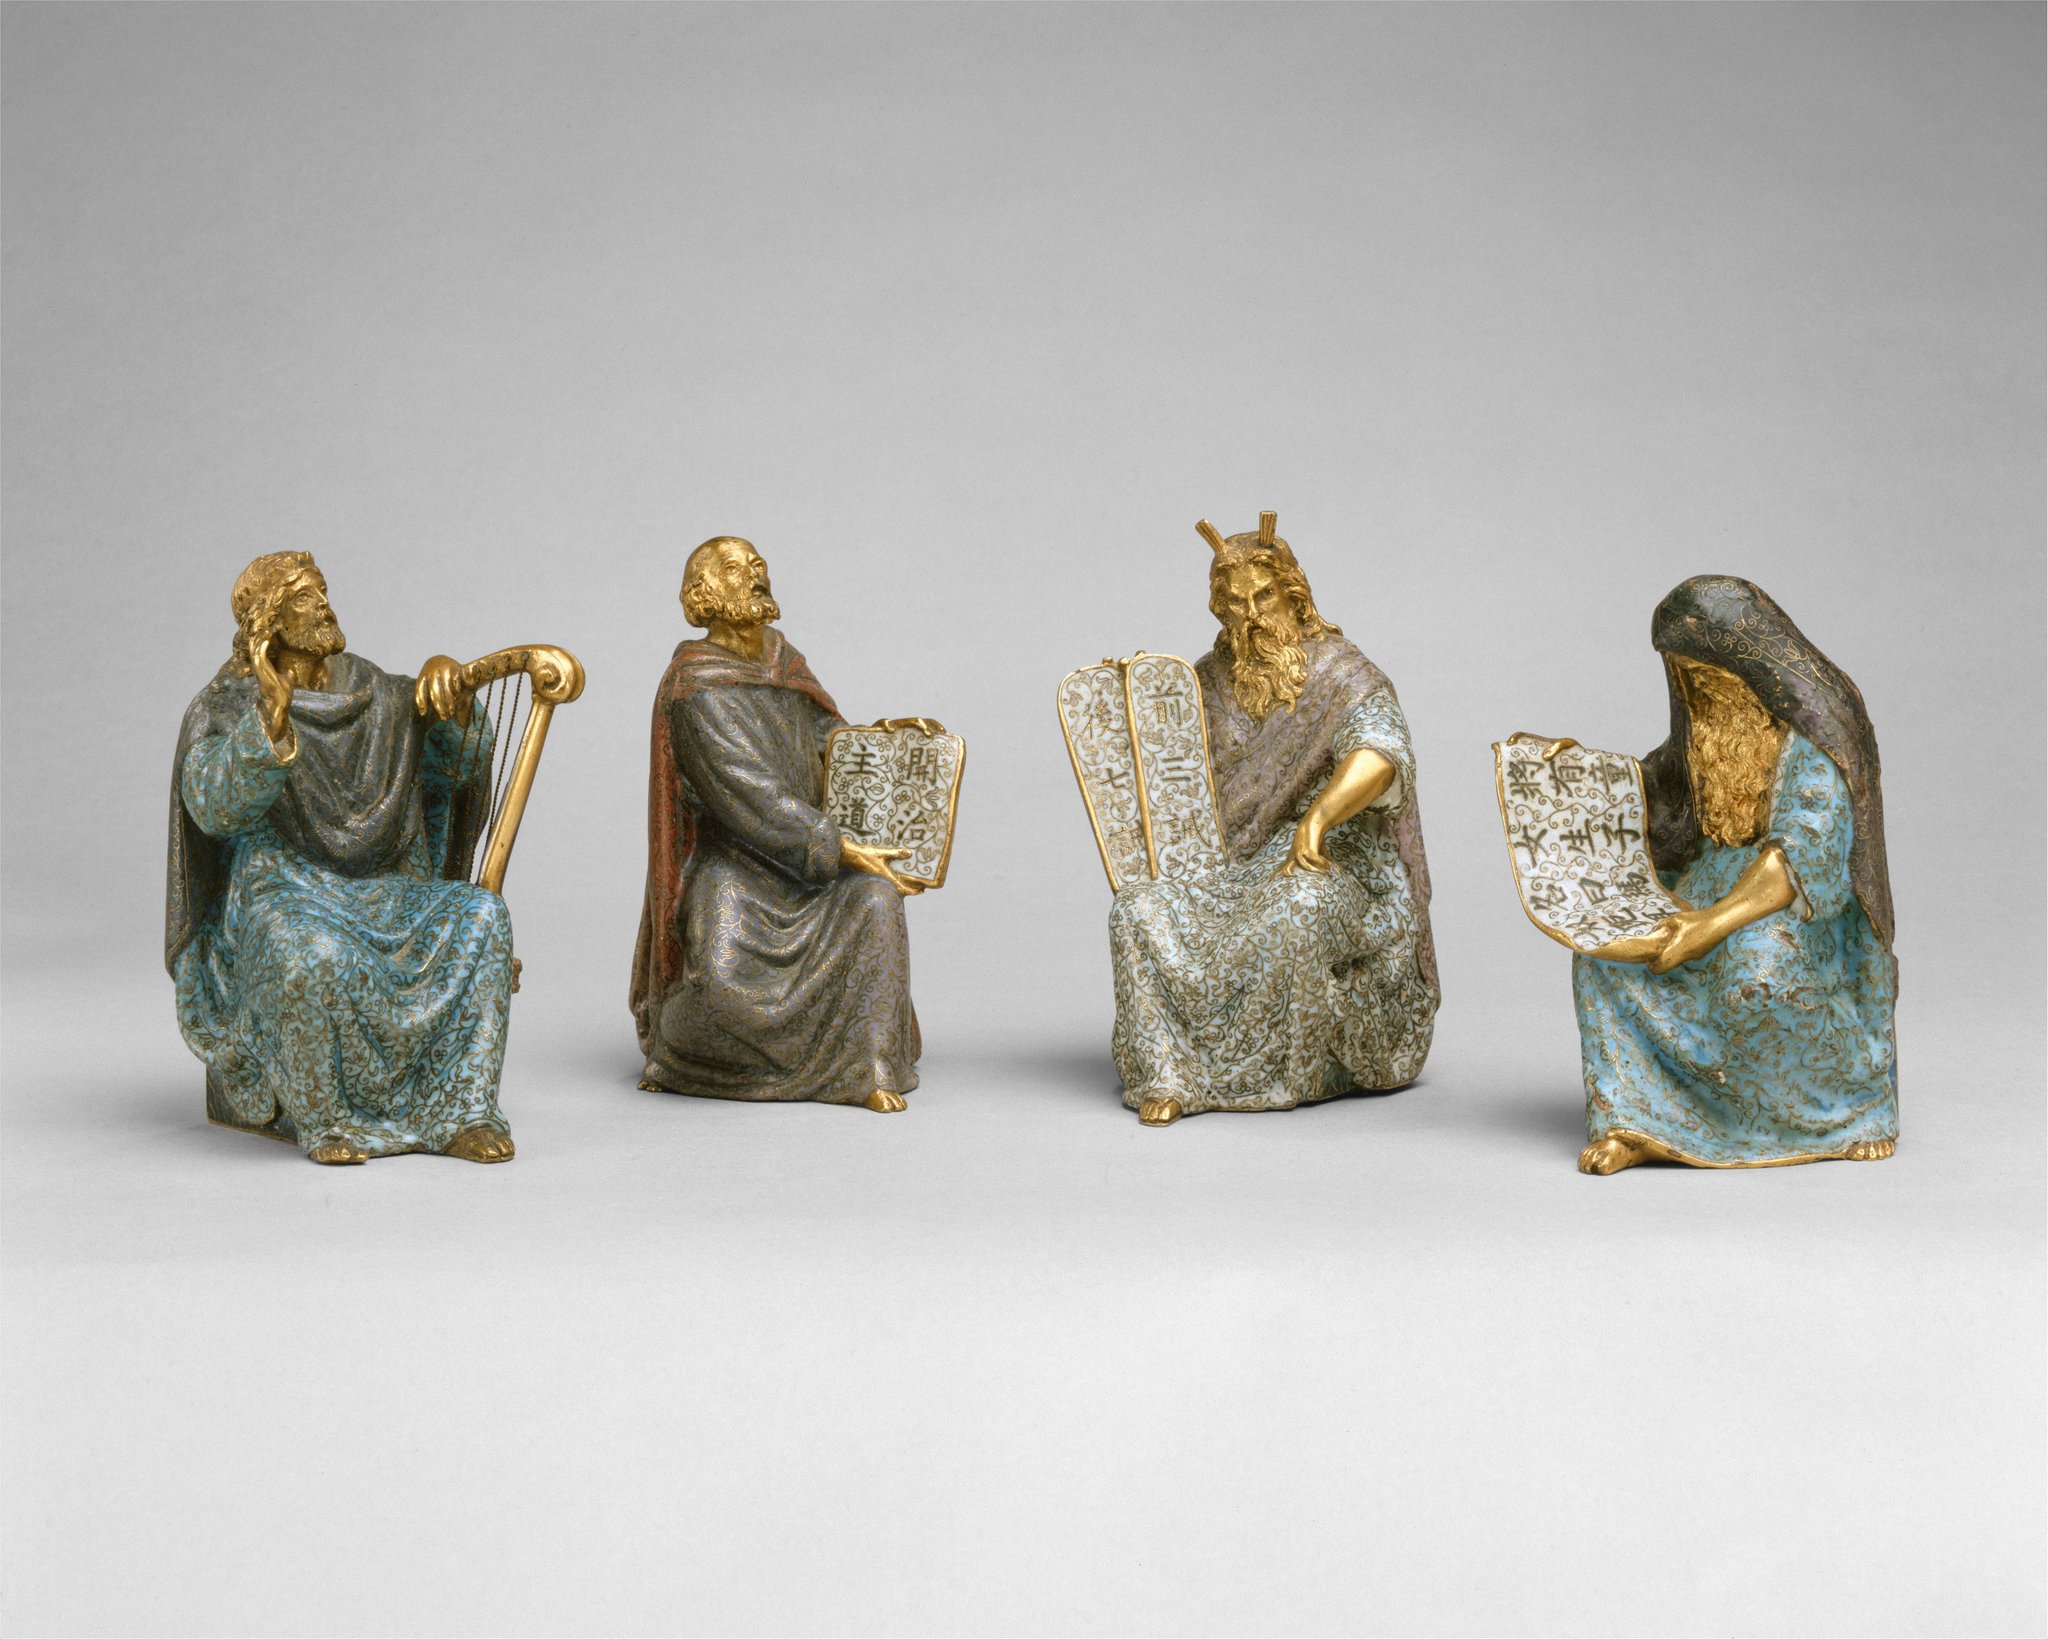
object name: figure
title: Old Testament figures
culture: chinese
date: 1701-1800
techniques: enamel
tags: tablets,men,harps